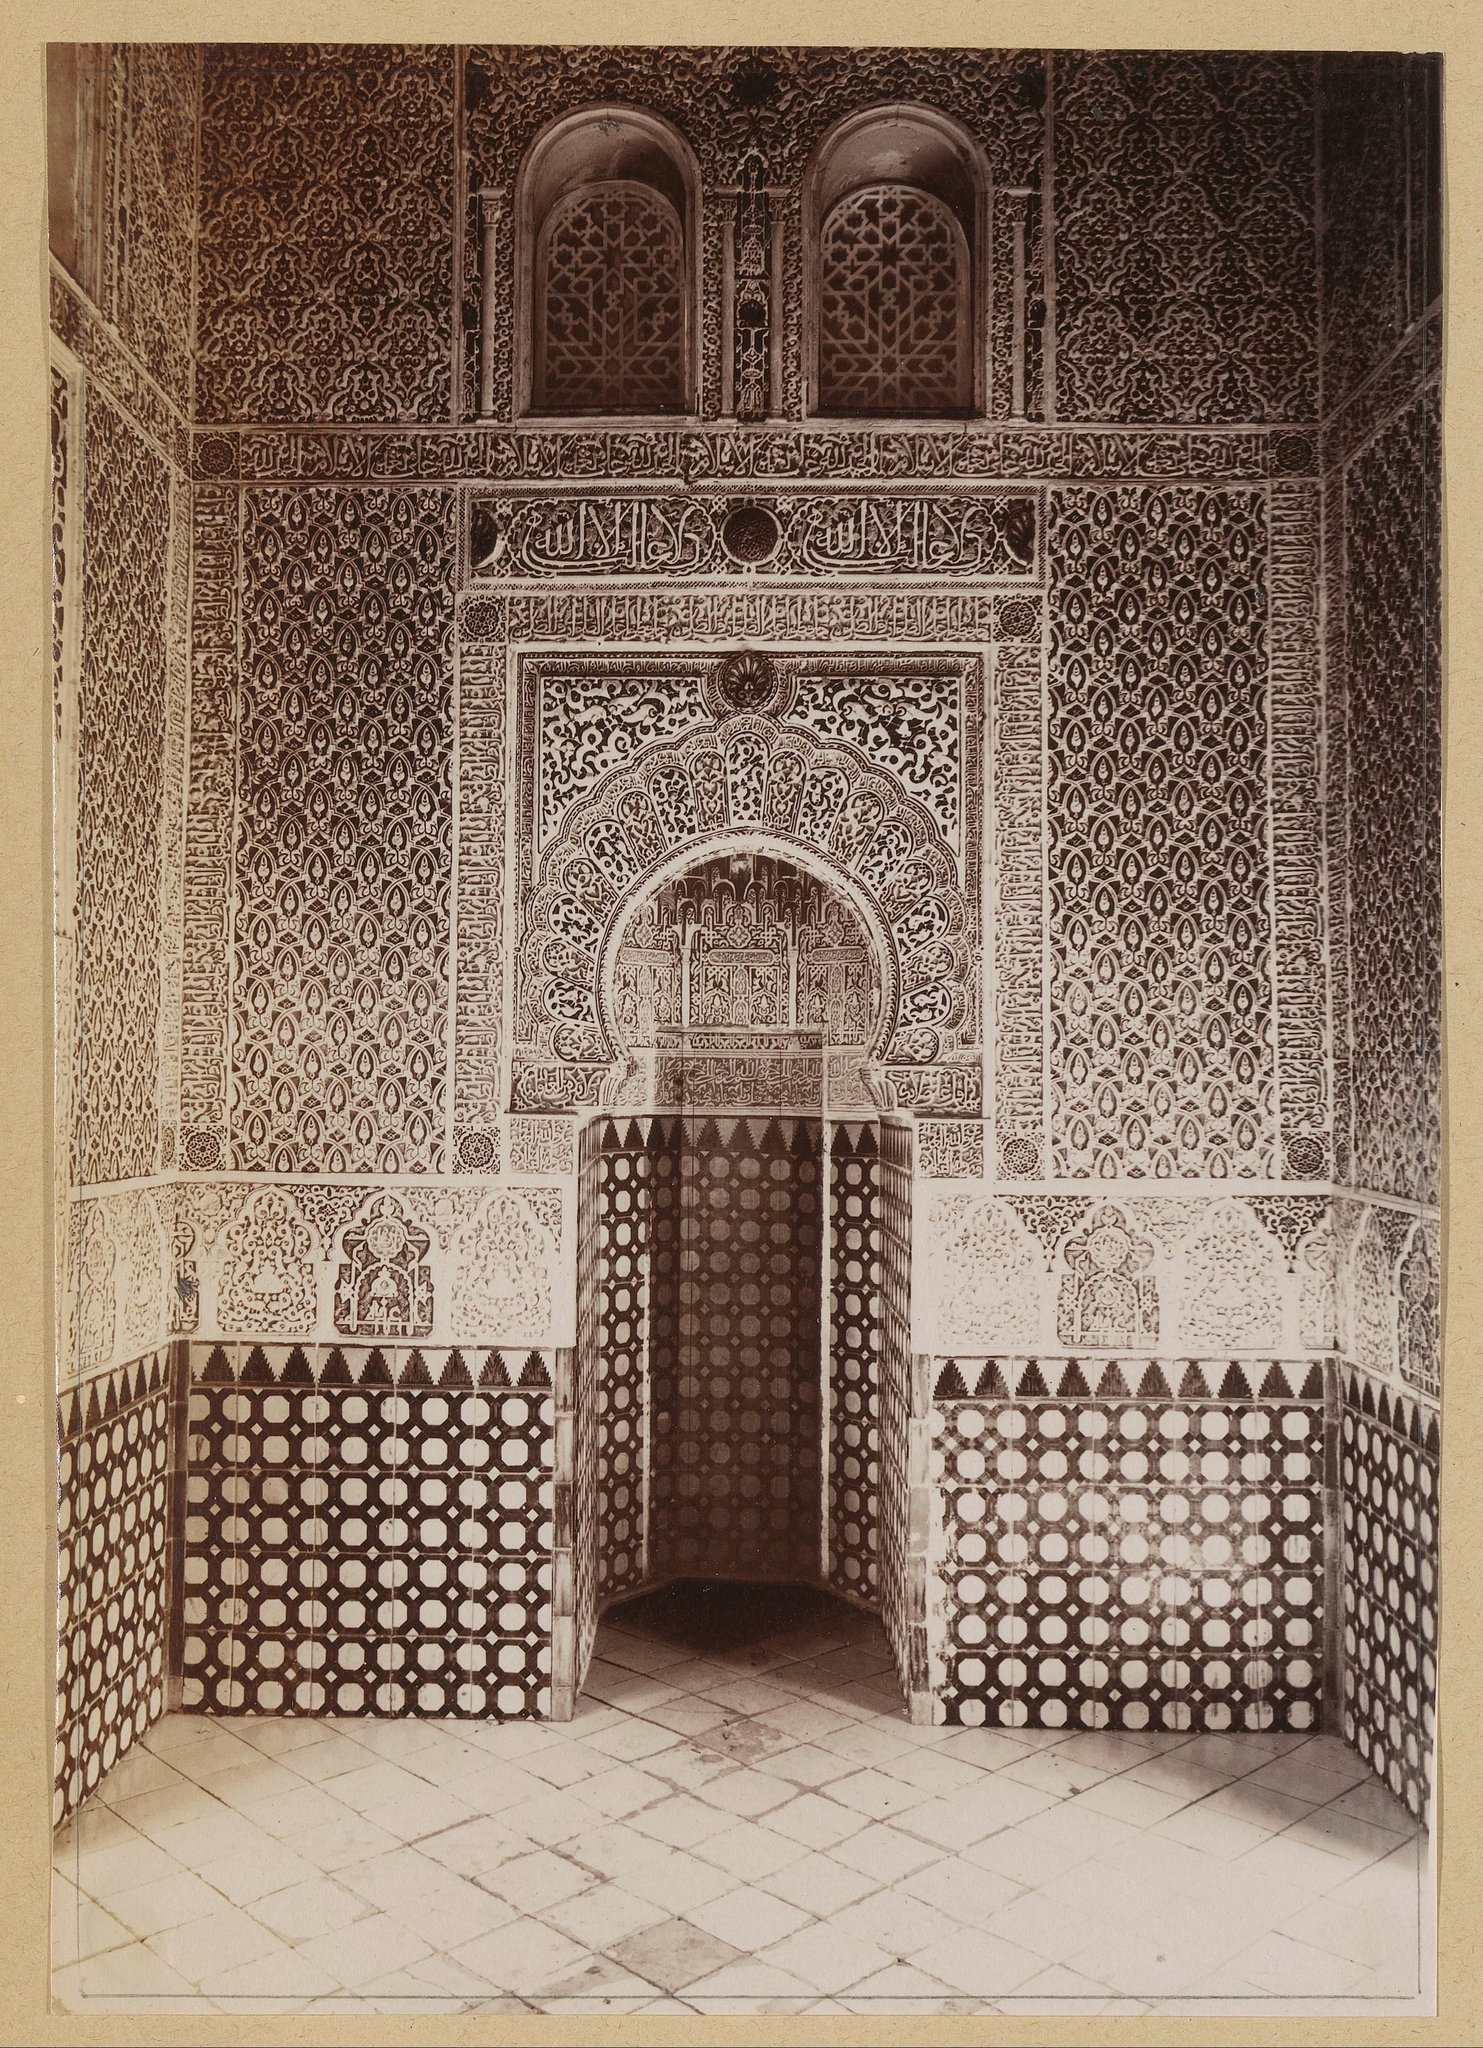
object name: album leaf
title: Gezicht op de mihrāb in het Alhambra in Granada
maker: Anonymous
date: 1851-1890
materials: paper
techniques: albumen print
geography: granada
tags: temple, shrine ~ islam, mohammedanism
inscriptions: inscription: ‘Alhambra, Mezquita del Coran/ Granada’